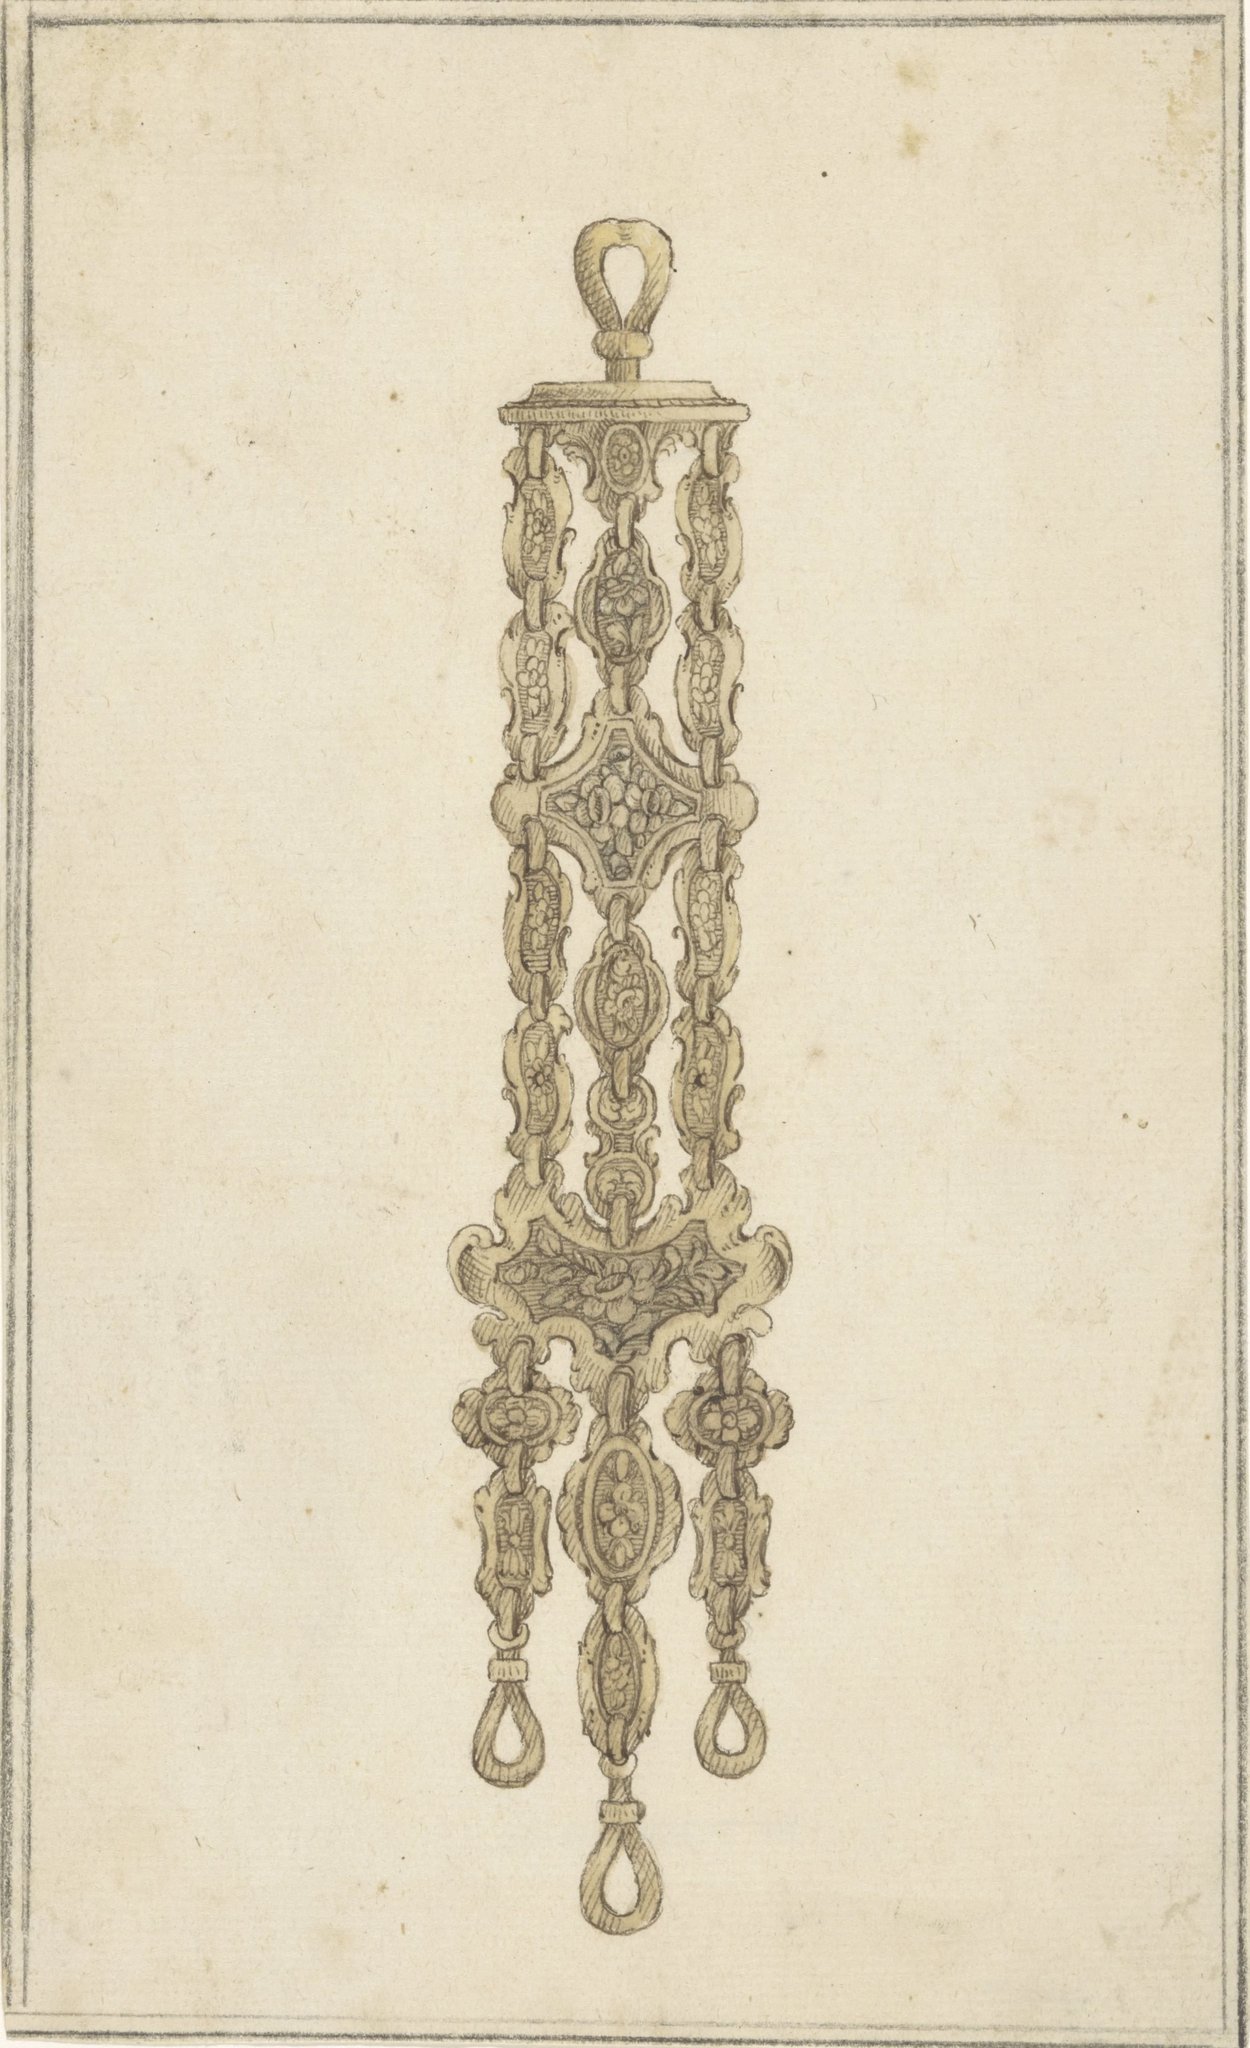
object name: design drawing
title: Ontwerp voor een chatelaine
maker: luigi valadier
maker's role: draughtsman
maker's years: 1726-1785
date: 1760-1780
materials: chalk, ink, paper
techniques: brush, pen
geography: rome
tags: watch